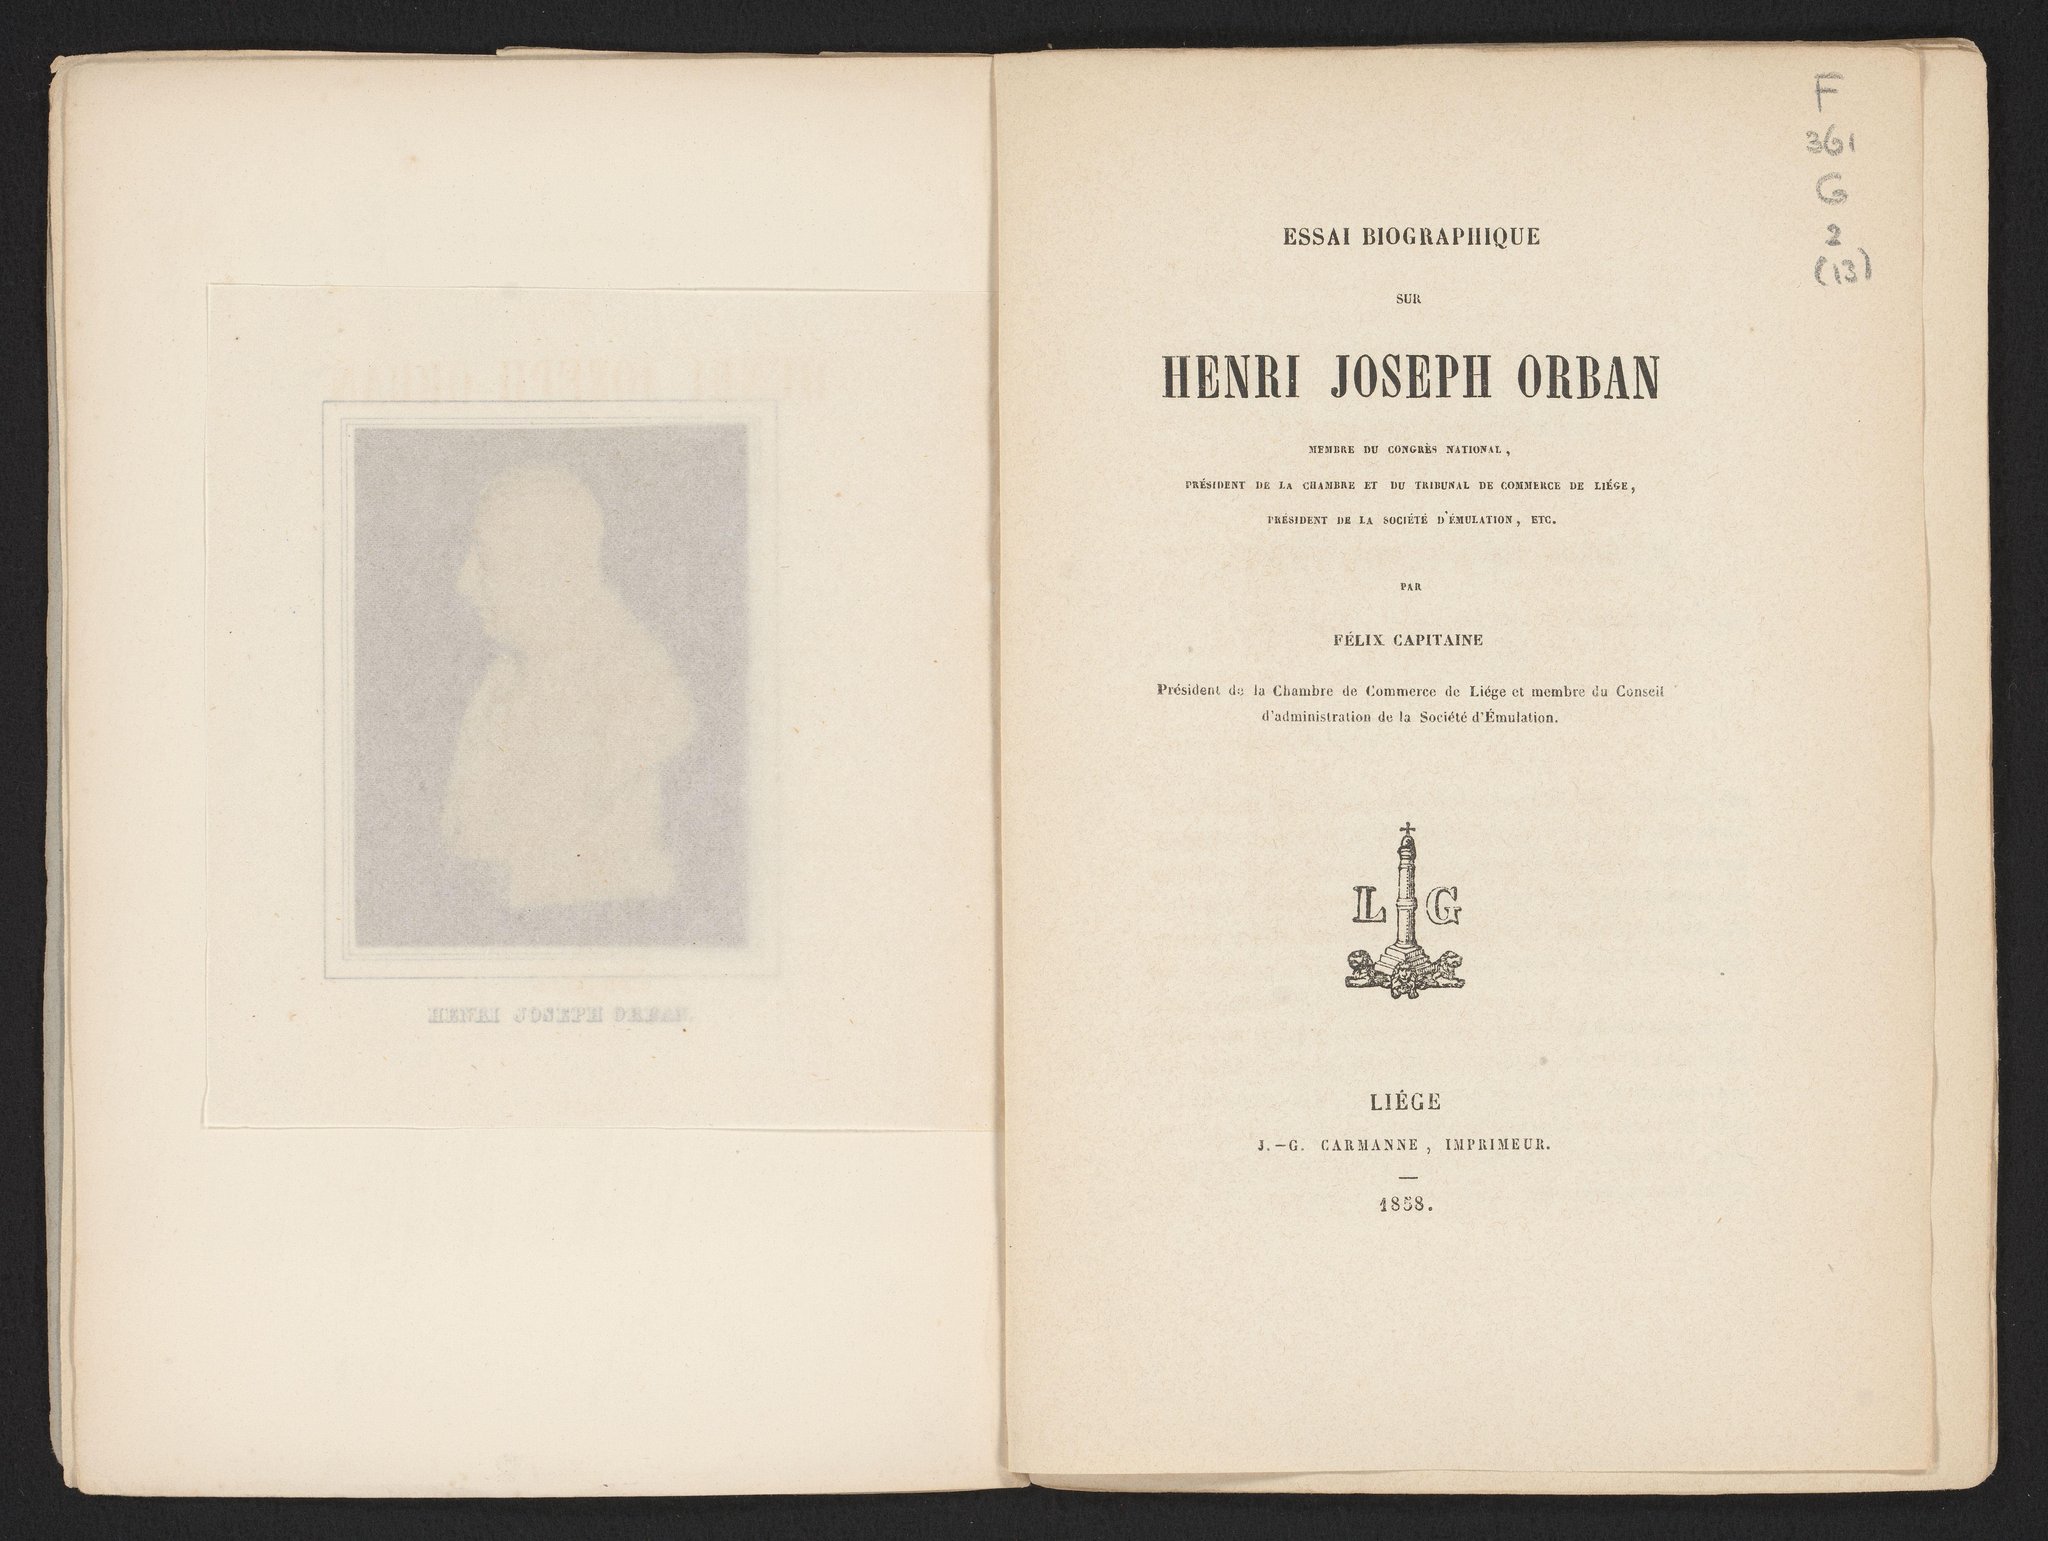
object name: book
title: Essai biographique sur Henri Joseph Orban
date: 1858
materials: paper, photographic support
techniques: albumen print, printing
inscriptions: annotation: ‘MAR/1996’